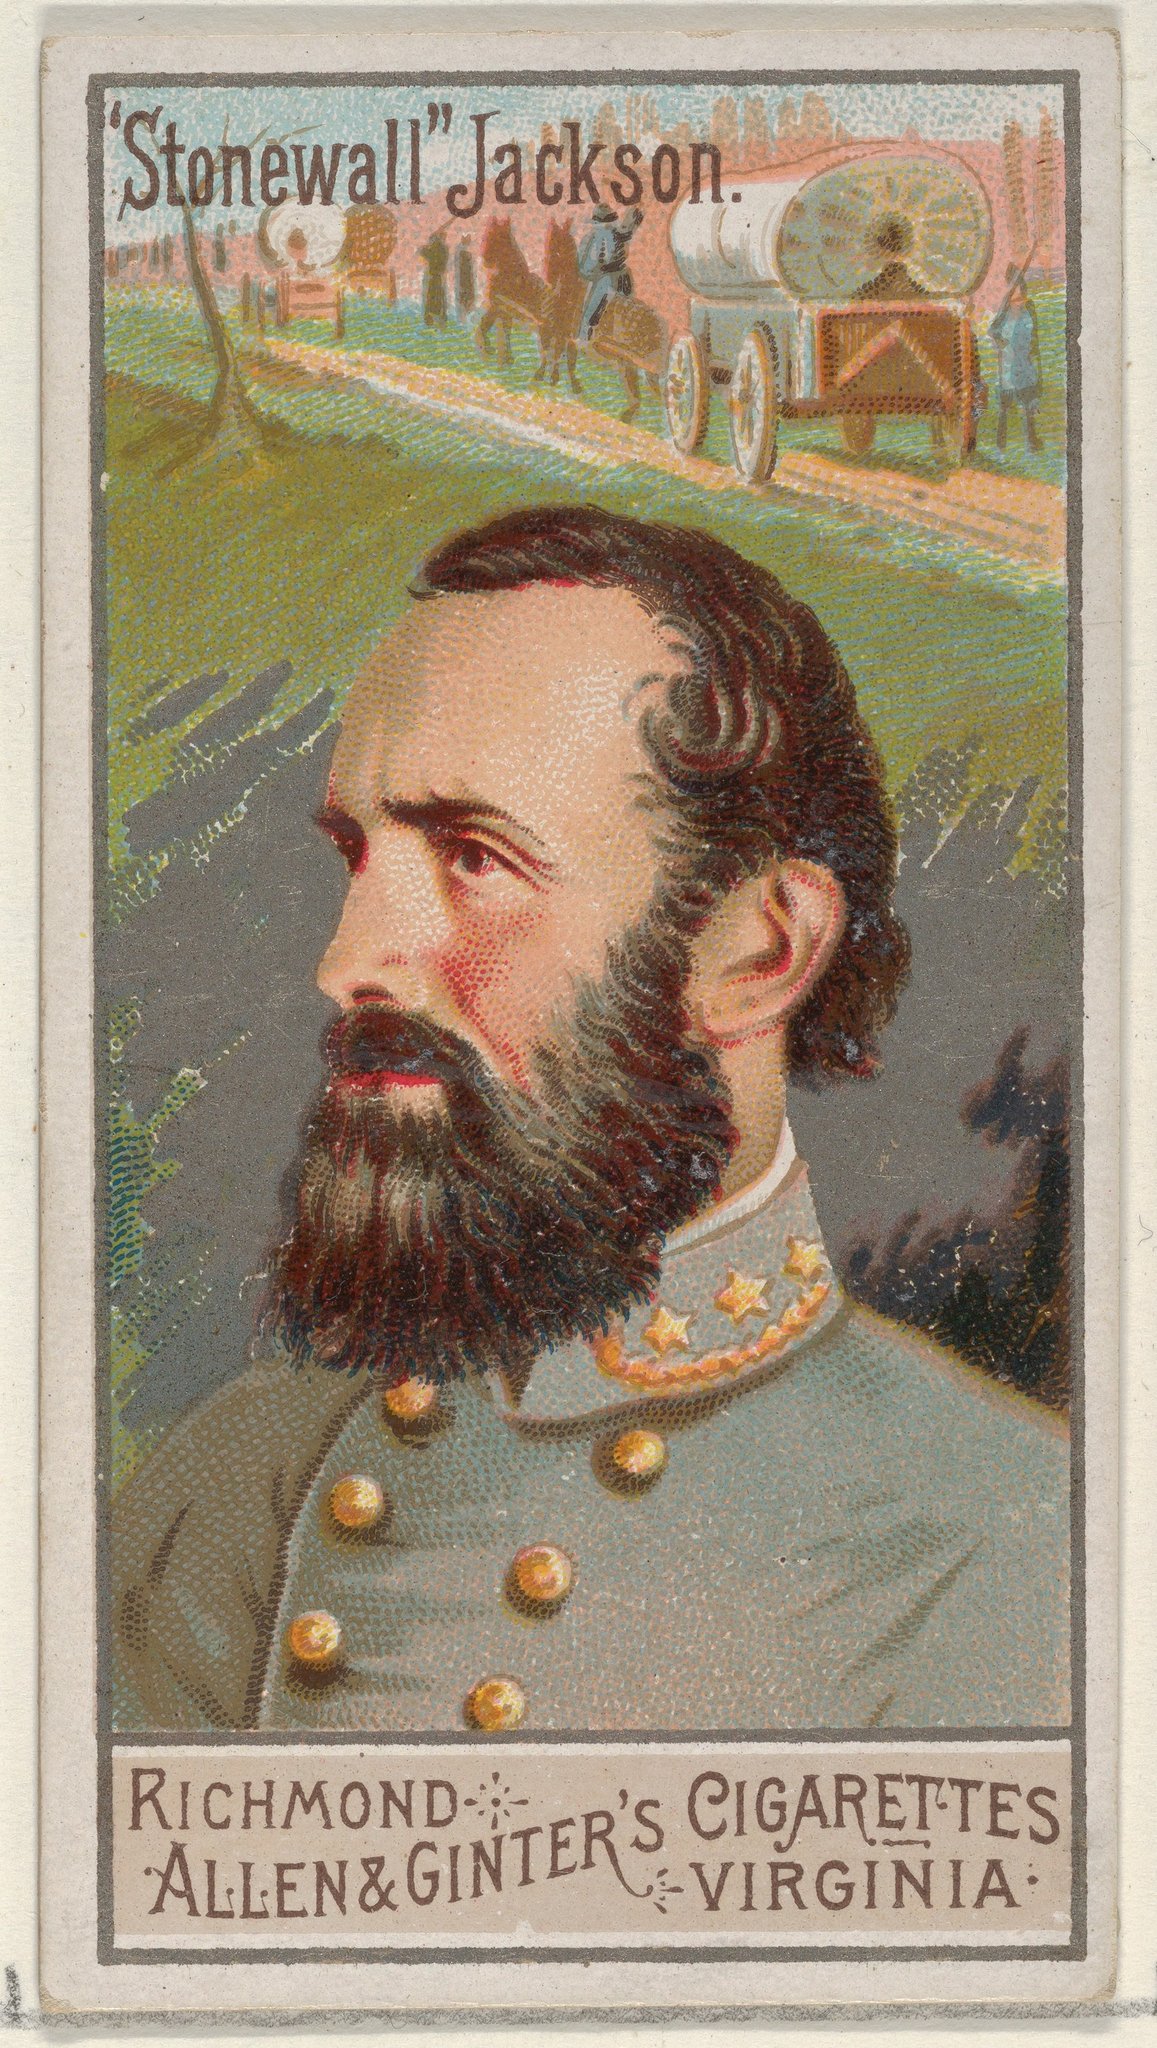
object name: print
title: "Stonewall" Jackson, from the Great Generals series (N15) for Allen & Ginter Cigarettes Brands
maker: allen & ginter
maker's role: publisher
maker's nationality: american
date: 1888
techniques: color lithograph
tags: men,generals